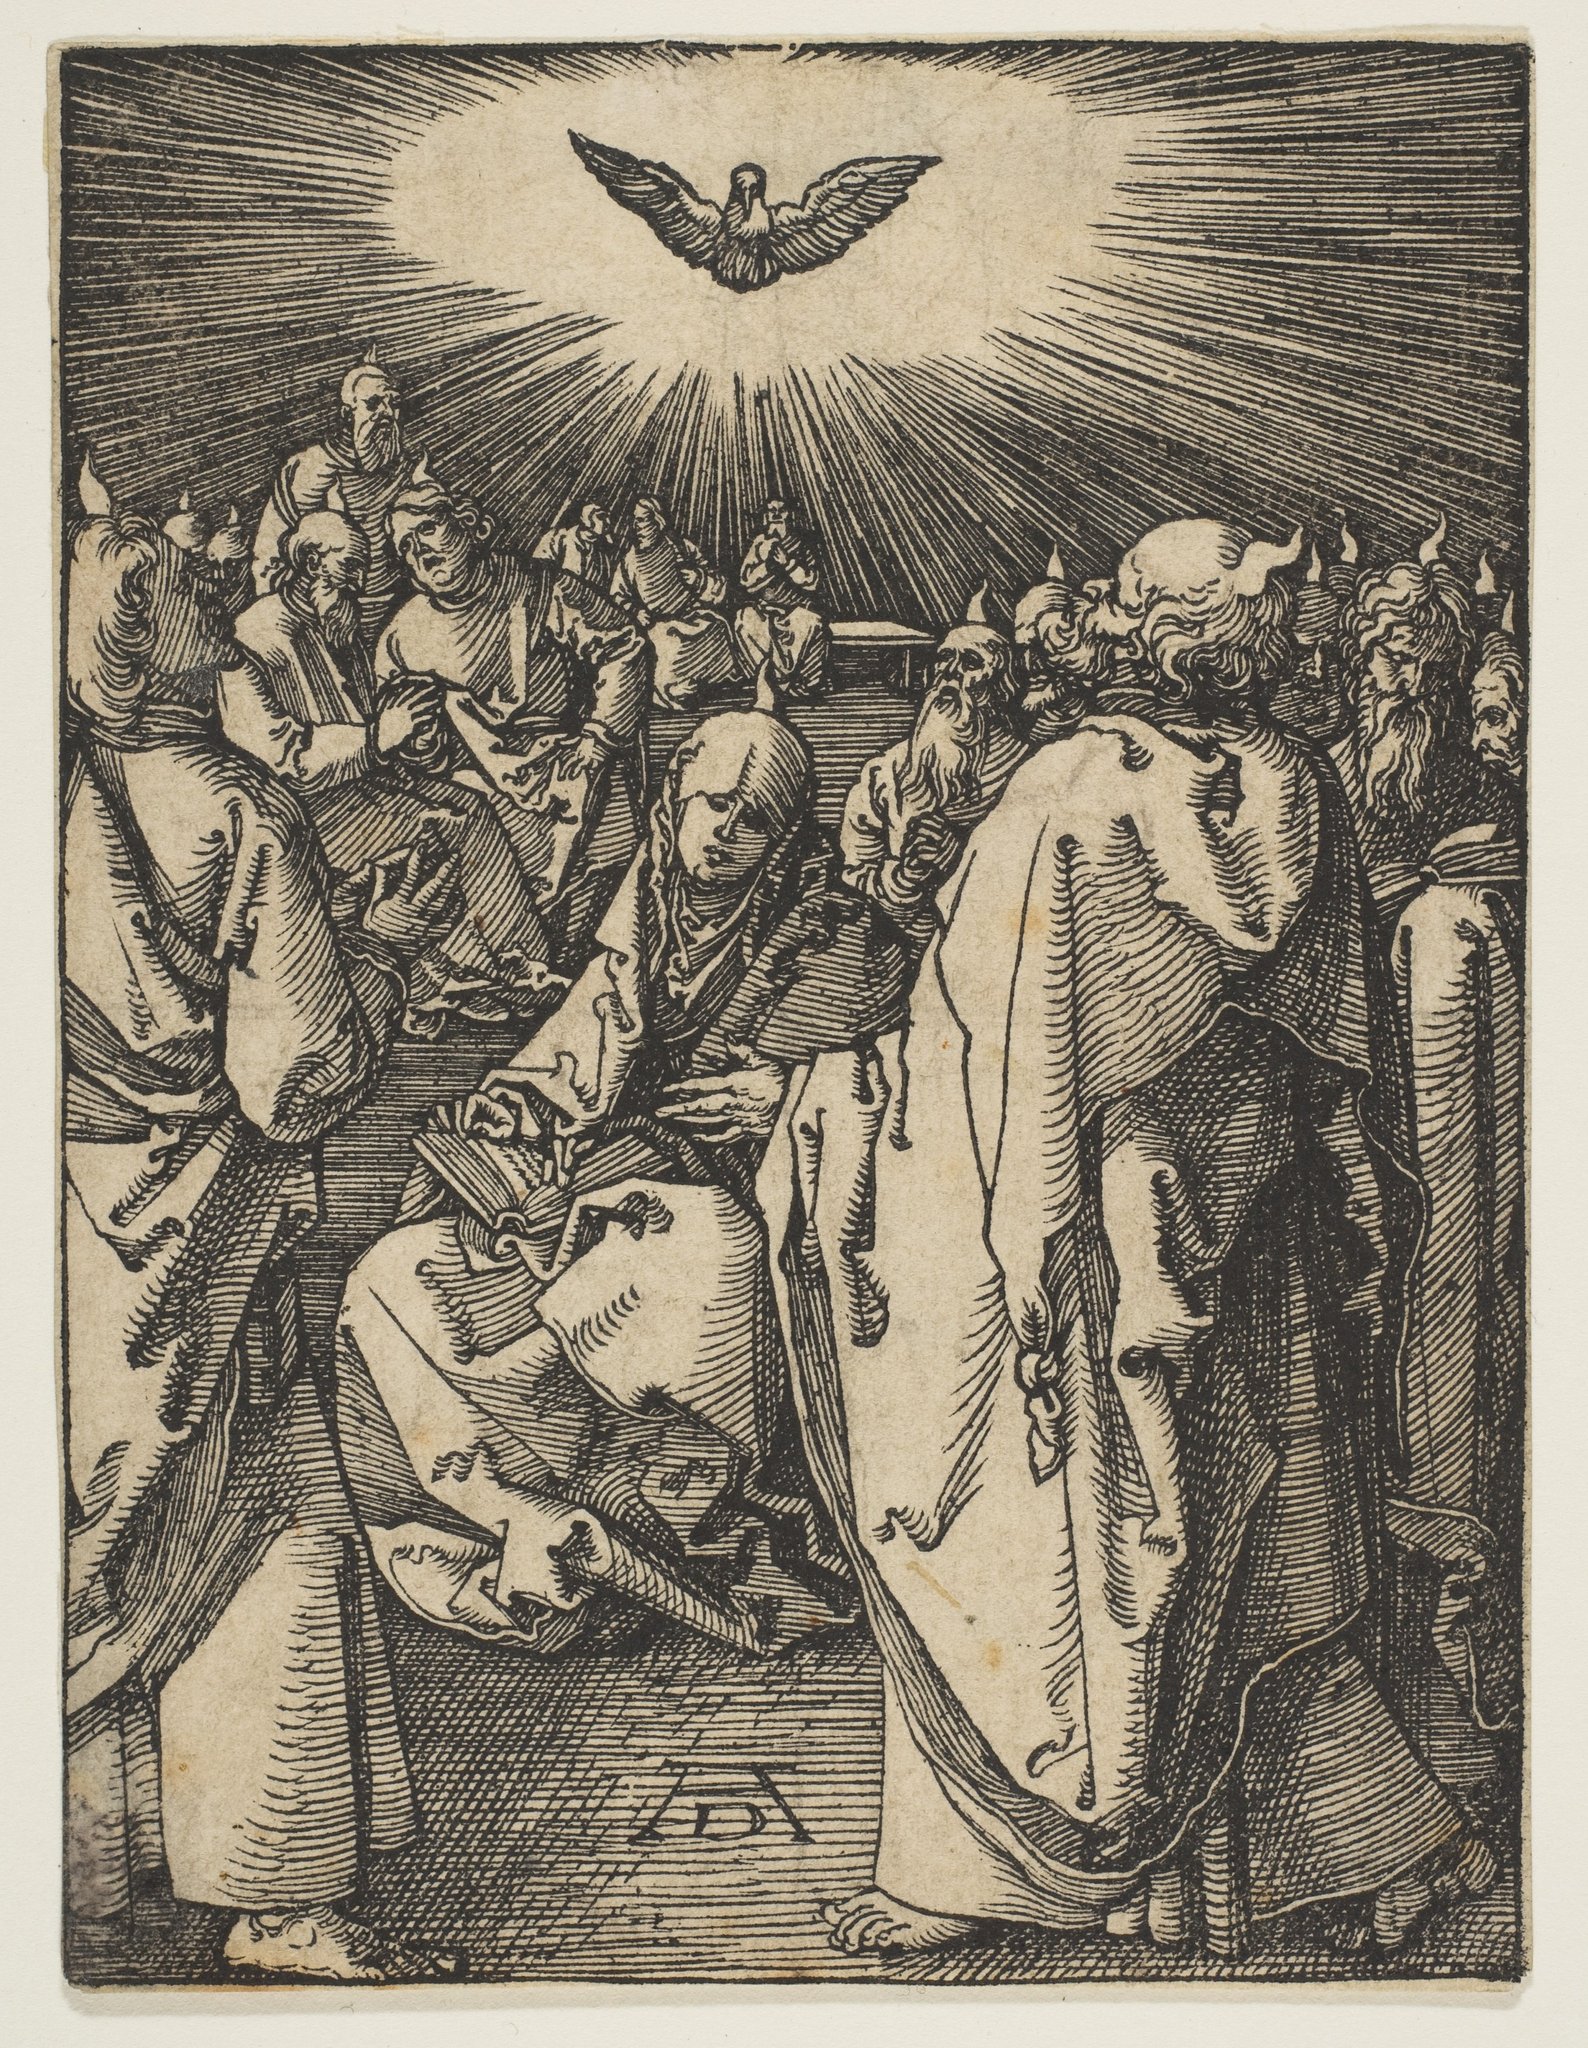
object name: print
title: Pentecost, from "The Small Passion"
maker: albrecht dürer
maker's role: artist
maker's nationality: german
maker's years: 1471-1528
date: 1510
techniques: woodcut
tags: pentecost